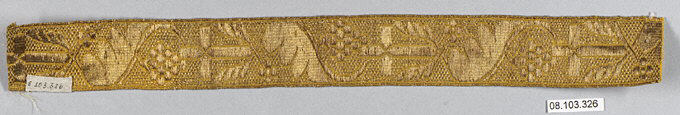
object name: galloon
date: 1801-1900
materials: metal thread, silk